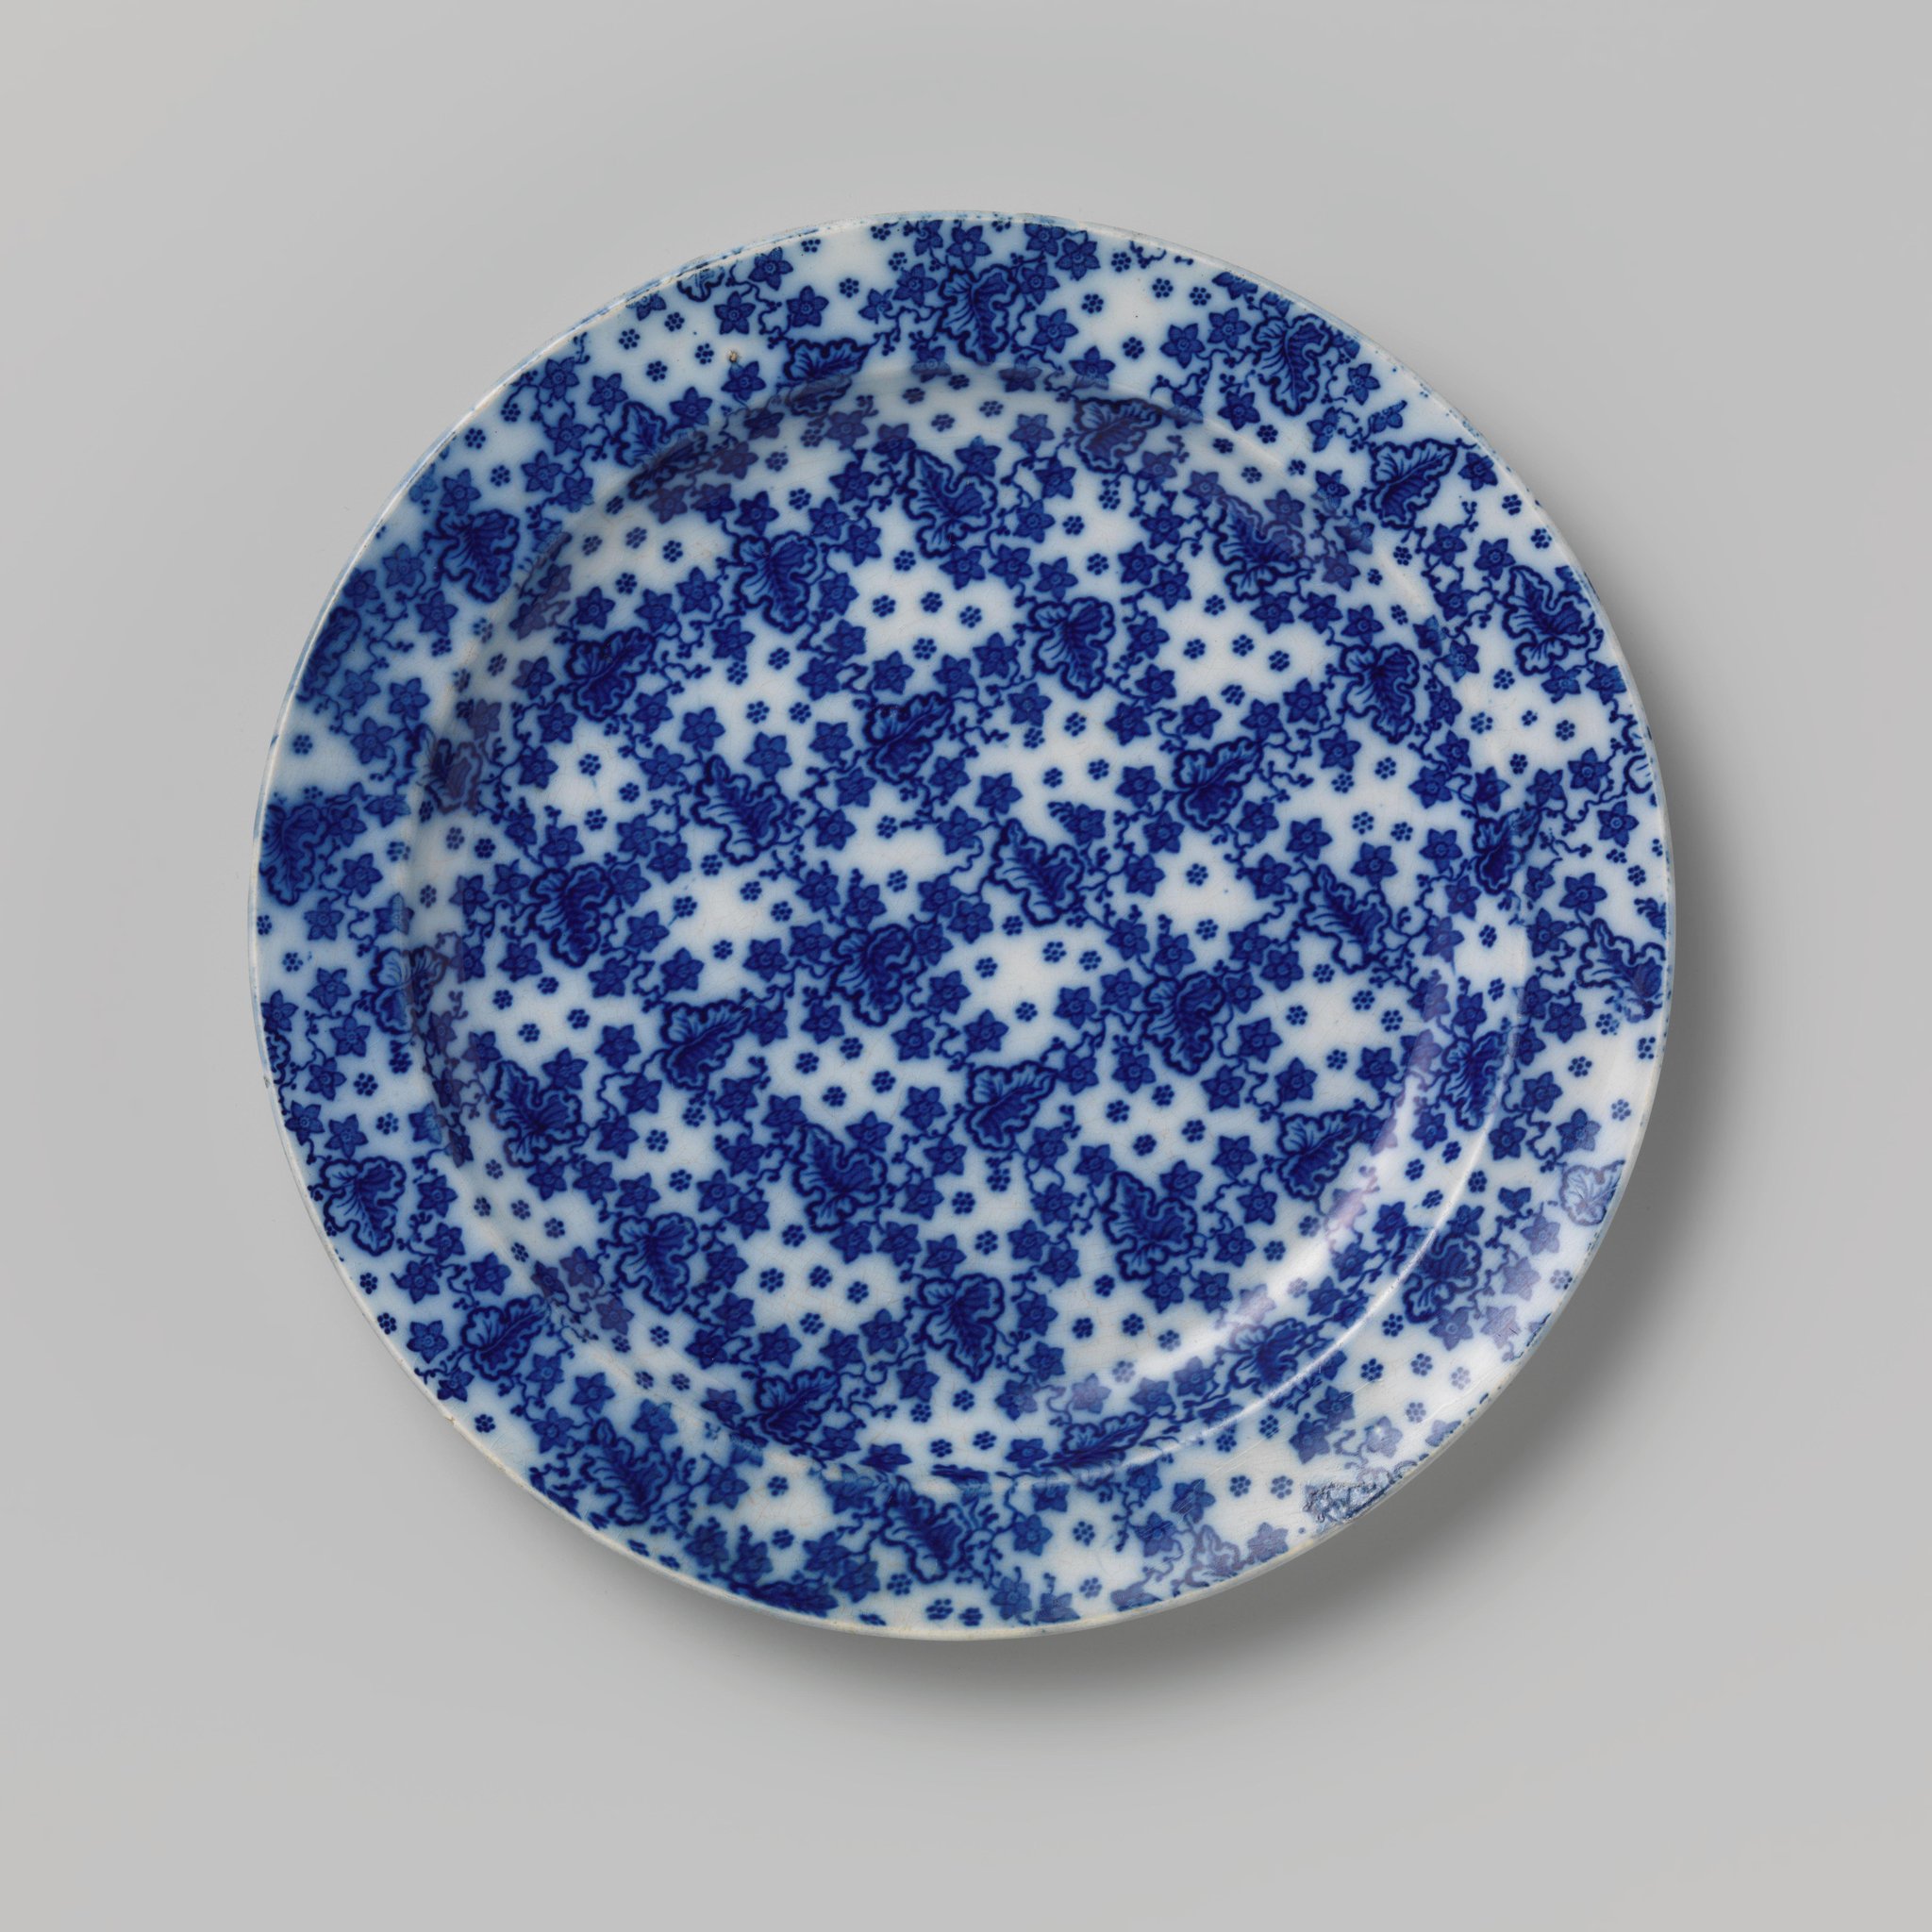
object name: plate dish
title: Bord met blauw bloem- en bladmotief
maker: petrus regout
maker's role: plateelbakker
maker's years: 1801-1879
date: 1850-1875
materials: creamware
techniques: transfer decoration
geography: maastricht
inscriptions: mark: ‘PARSEME // No 1 en het cijfer 1’, check stamp: ‘P. REGOUT // 17 // MAASTRICHT’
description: Bord van aardewerk met vloeiblauw transferdecor, rond, met blauw bloem- en bladmotief op plat en rand.